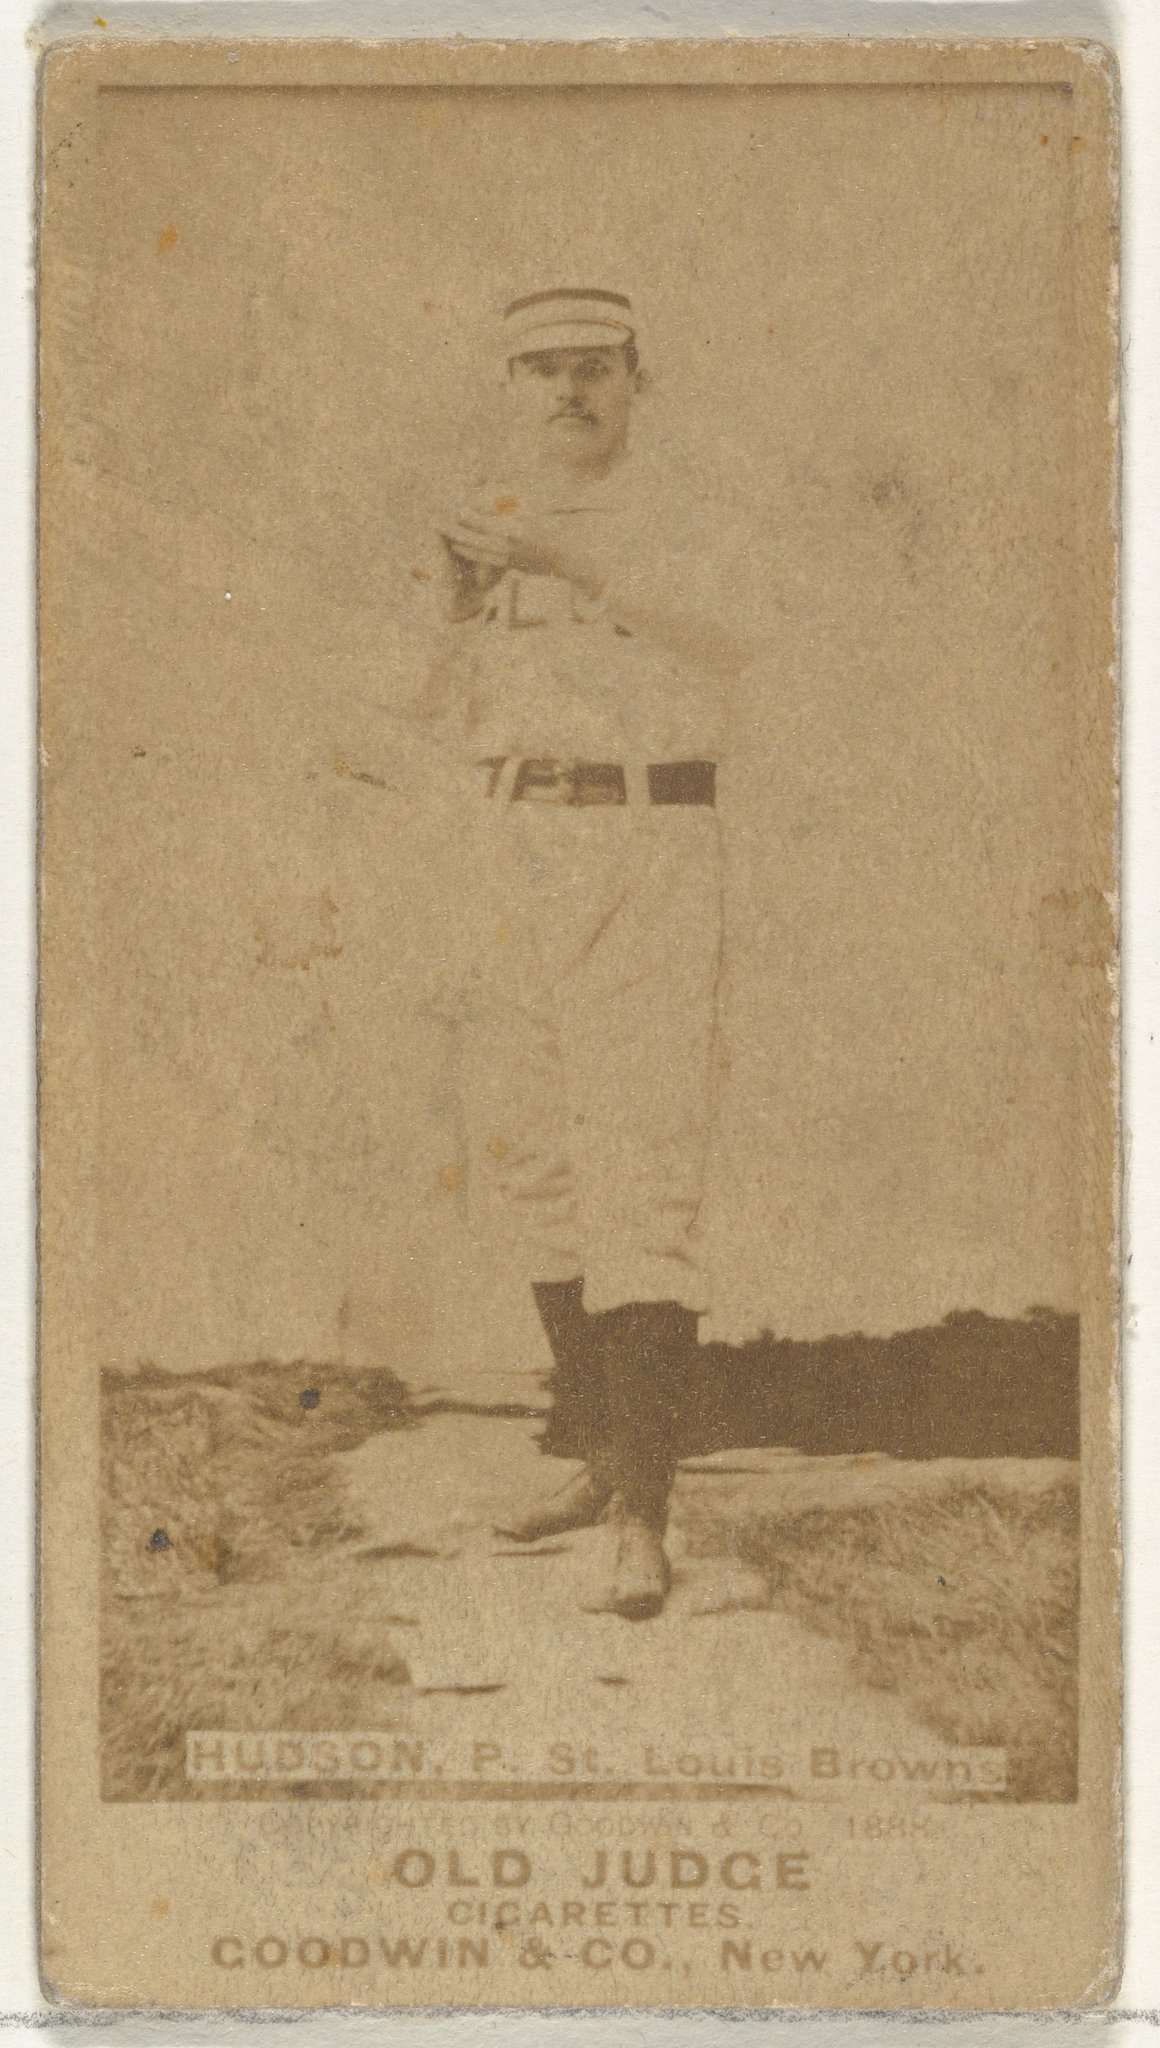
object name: baseball card, photograph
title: Nathaniel P. "Nat" Hudson, Pitcher, St. Louis Browns, from the Old Judge series (N172) for Old Judge Cigarettes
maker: goodwin & company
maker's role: publisher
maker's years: 1850-1950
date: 1888-1889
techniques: albumen silver print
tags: men,portraits,baseball,athletes